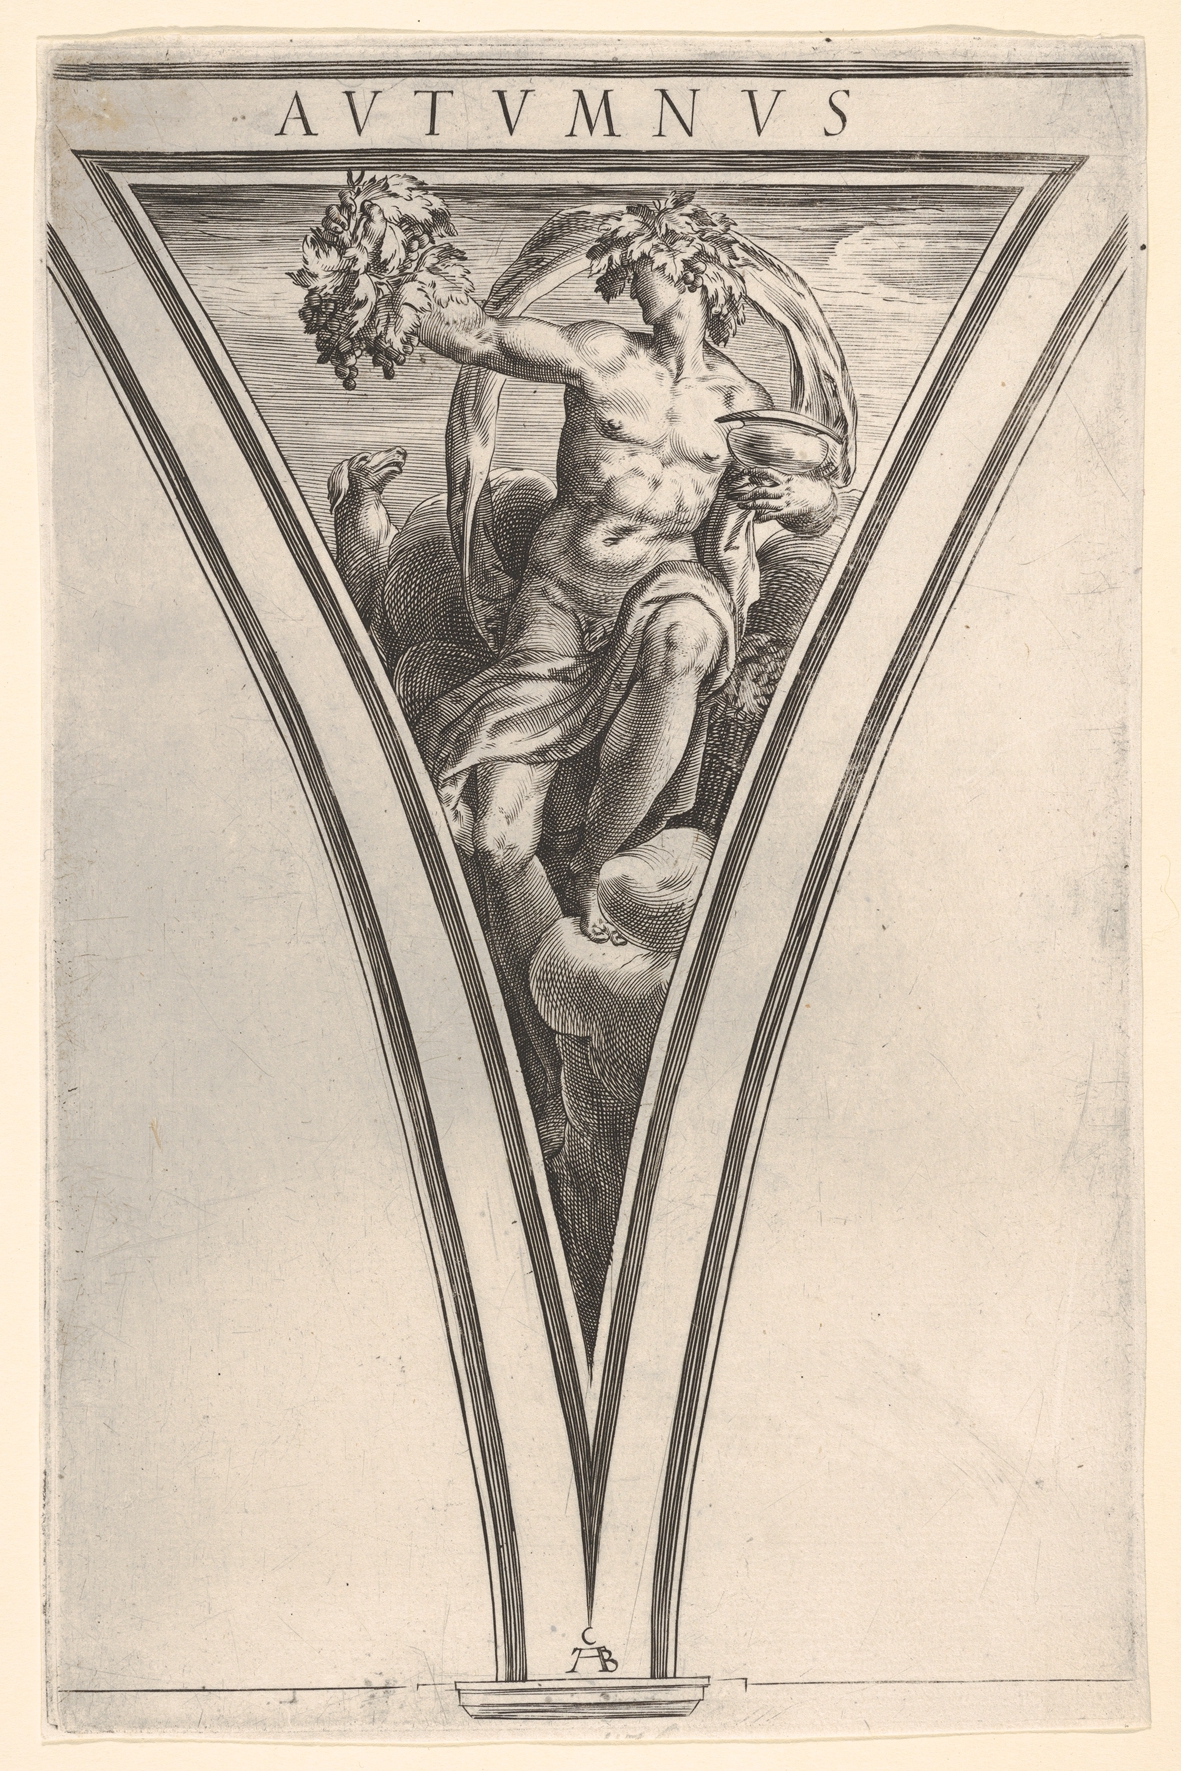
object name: print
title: Autumn (Autumnus), represented as a seated male figure bearing grapes in his right hand and a lidded vessel in his left hand, with a billowing drape and grape wreath, a spandrel-shaped composition from "The Four Seasons"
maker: cherubino alberti (zaccaria mattia)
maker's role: artist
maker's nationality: italian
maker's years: 1553-1615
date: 1570-1615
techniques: engraving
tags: male nudes,dogs